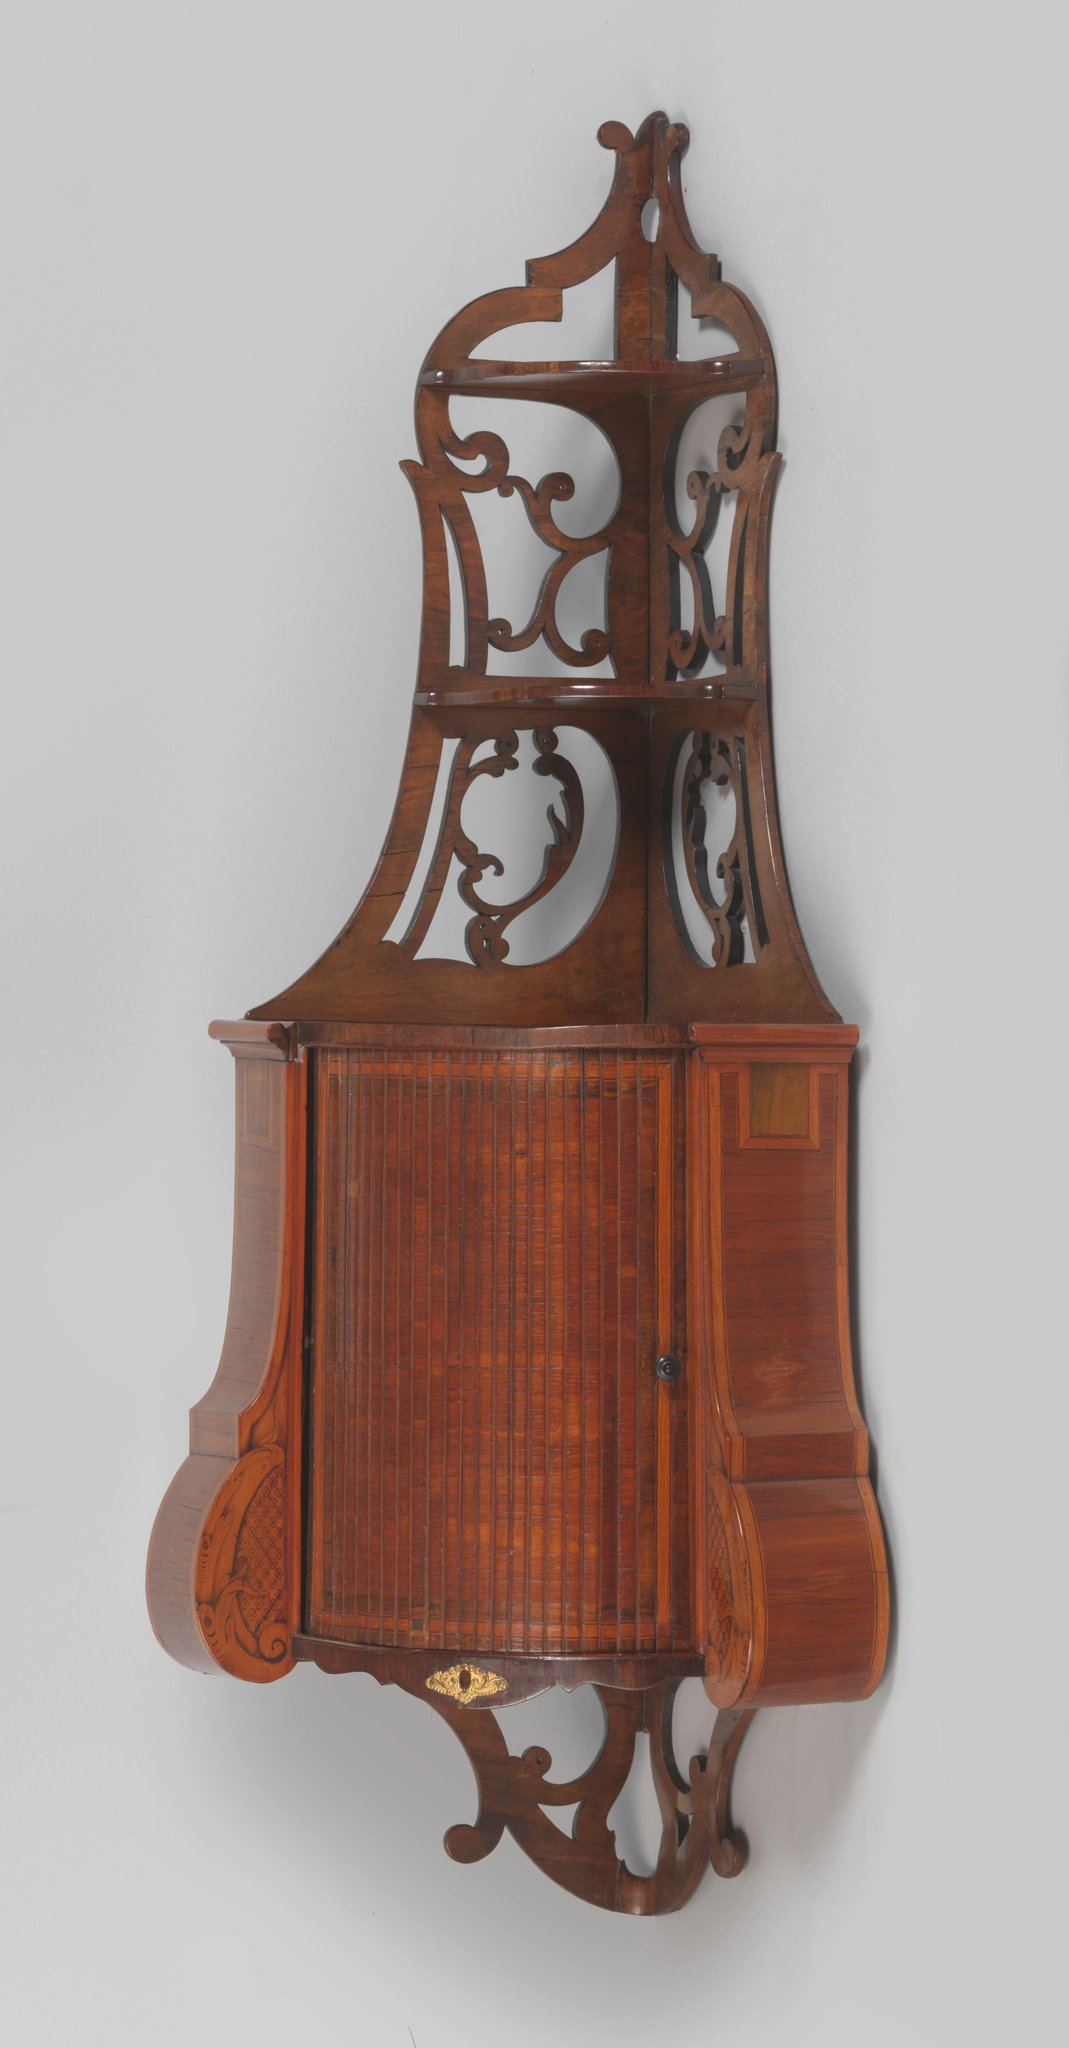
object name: case furniture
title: Hoekétagère met jalouziedeur, versierd met marqueterie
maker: Anonymous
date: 1750-1775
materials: wood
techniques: marquetry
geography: northern netherlands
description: Corner étagère. Oak, veneered with tulipwood and other woods. Netherlands, c. 1765 - 1775.